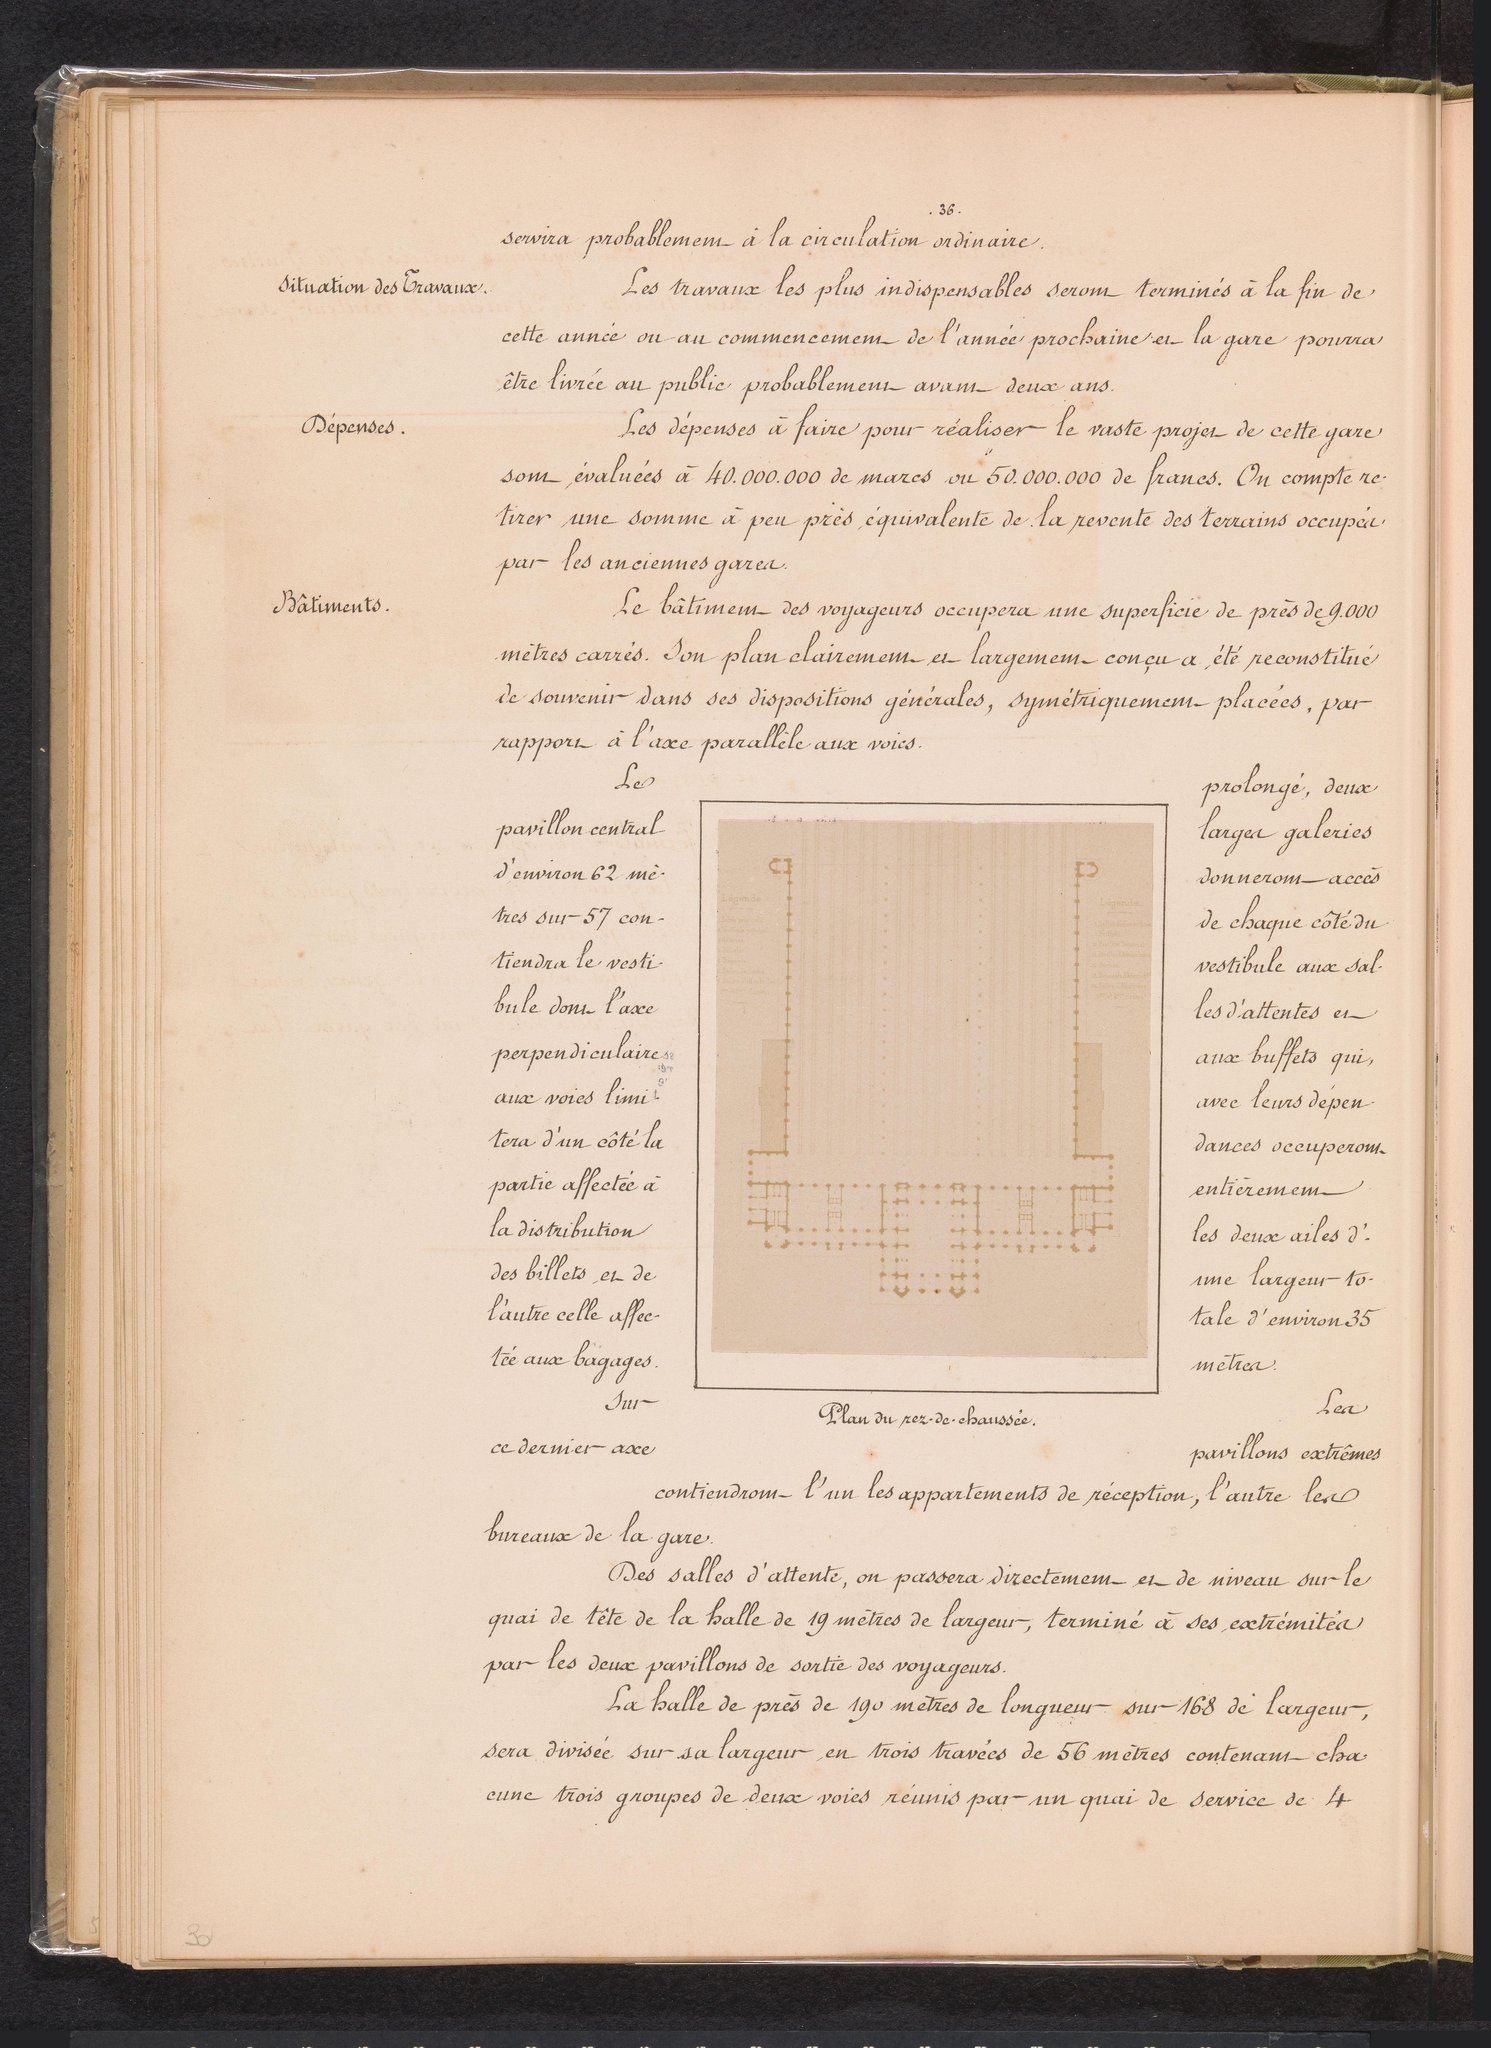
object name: page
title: Fotoreproductie van een plattegrond van Frankfurt Hauptbahnhof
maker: Anonymous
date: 1874-1884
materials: photographic support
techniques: albumen print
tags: maps, atlases, railway, train, station; shelter (railway, tramway)